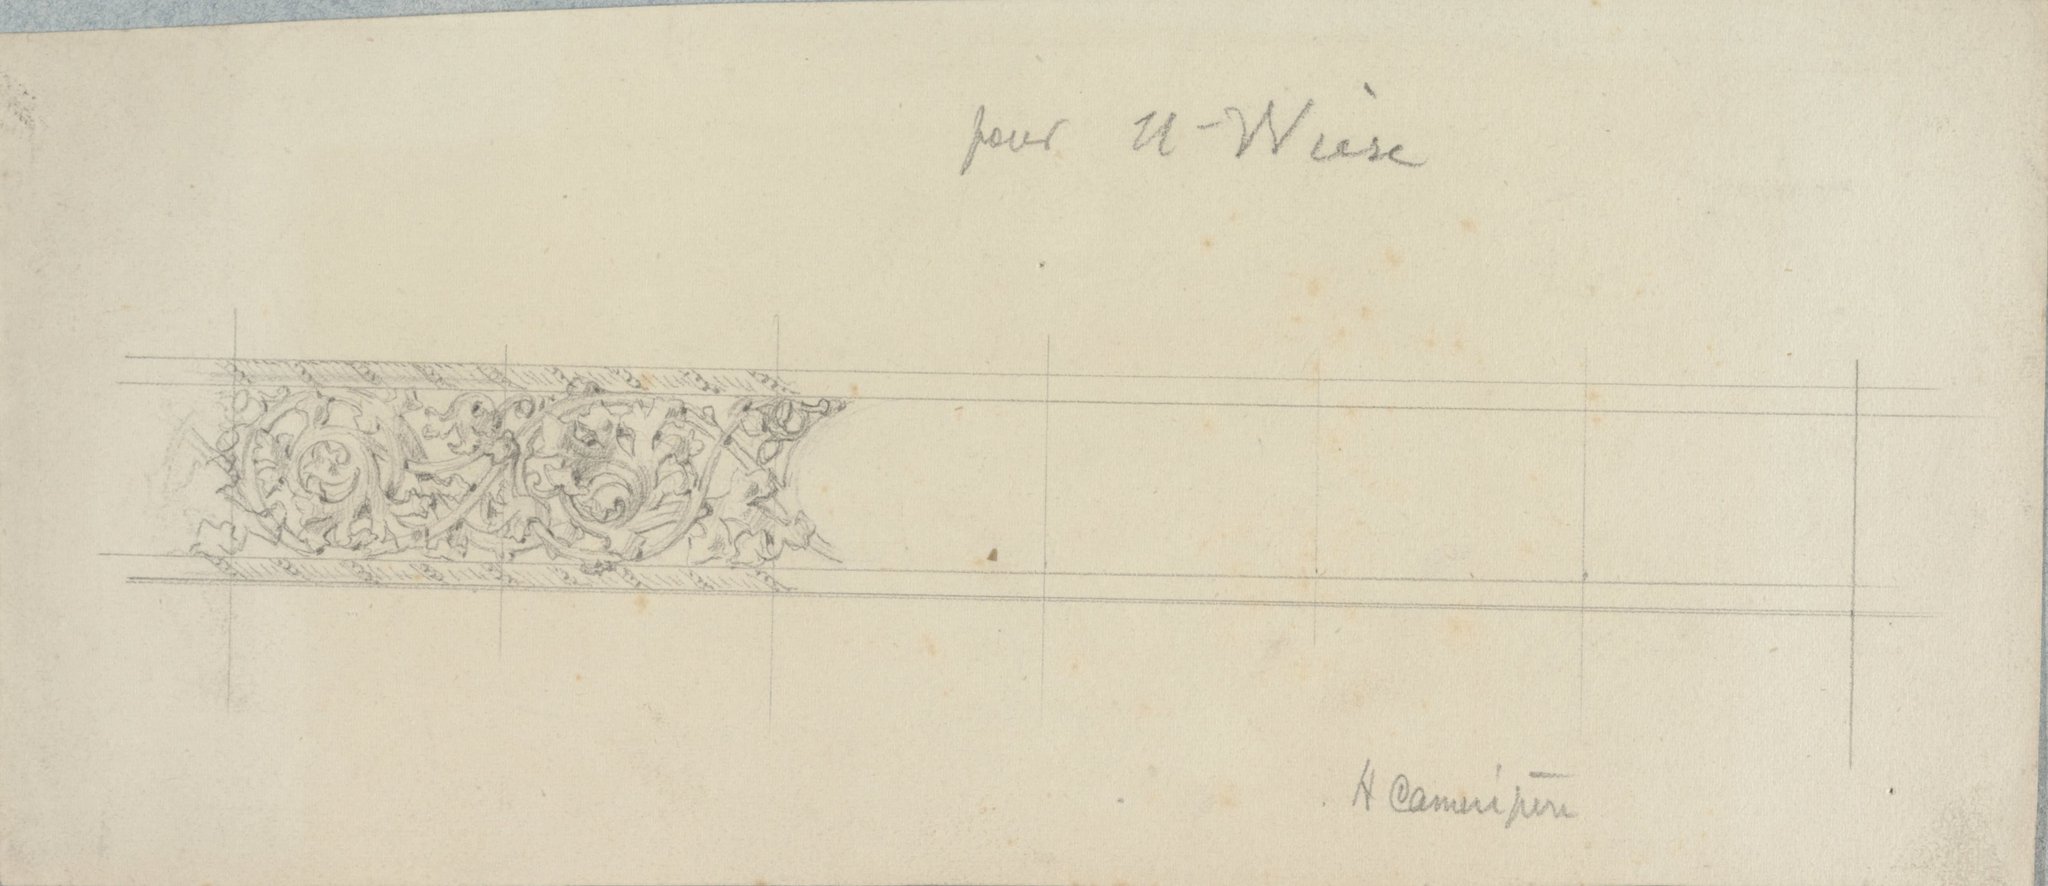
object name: design drawing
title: Design for a Bracelet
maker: henri cameré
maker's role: designer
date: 1864-1894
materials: paper, pencil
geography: paris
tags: bracelet, wristlet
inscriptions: inscription: ‘pour U Wièse / H Cameré père’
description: This bracelet design wonderfully illustrates the design process. Although not all of the links are worked out or coloured in, the motif has been laid down. Inscribed at the upper right is pour U Wiese, perhaps referring to the French goldsmith Jules Wièse. The scrollwork of the acanthus leaves is a recurring motif in the neo-styles and used in jewellery by both Wièse and Froment-Meurice.